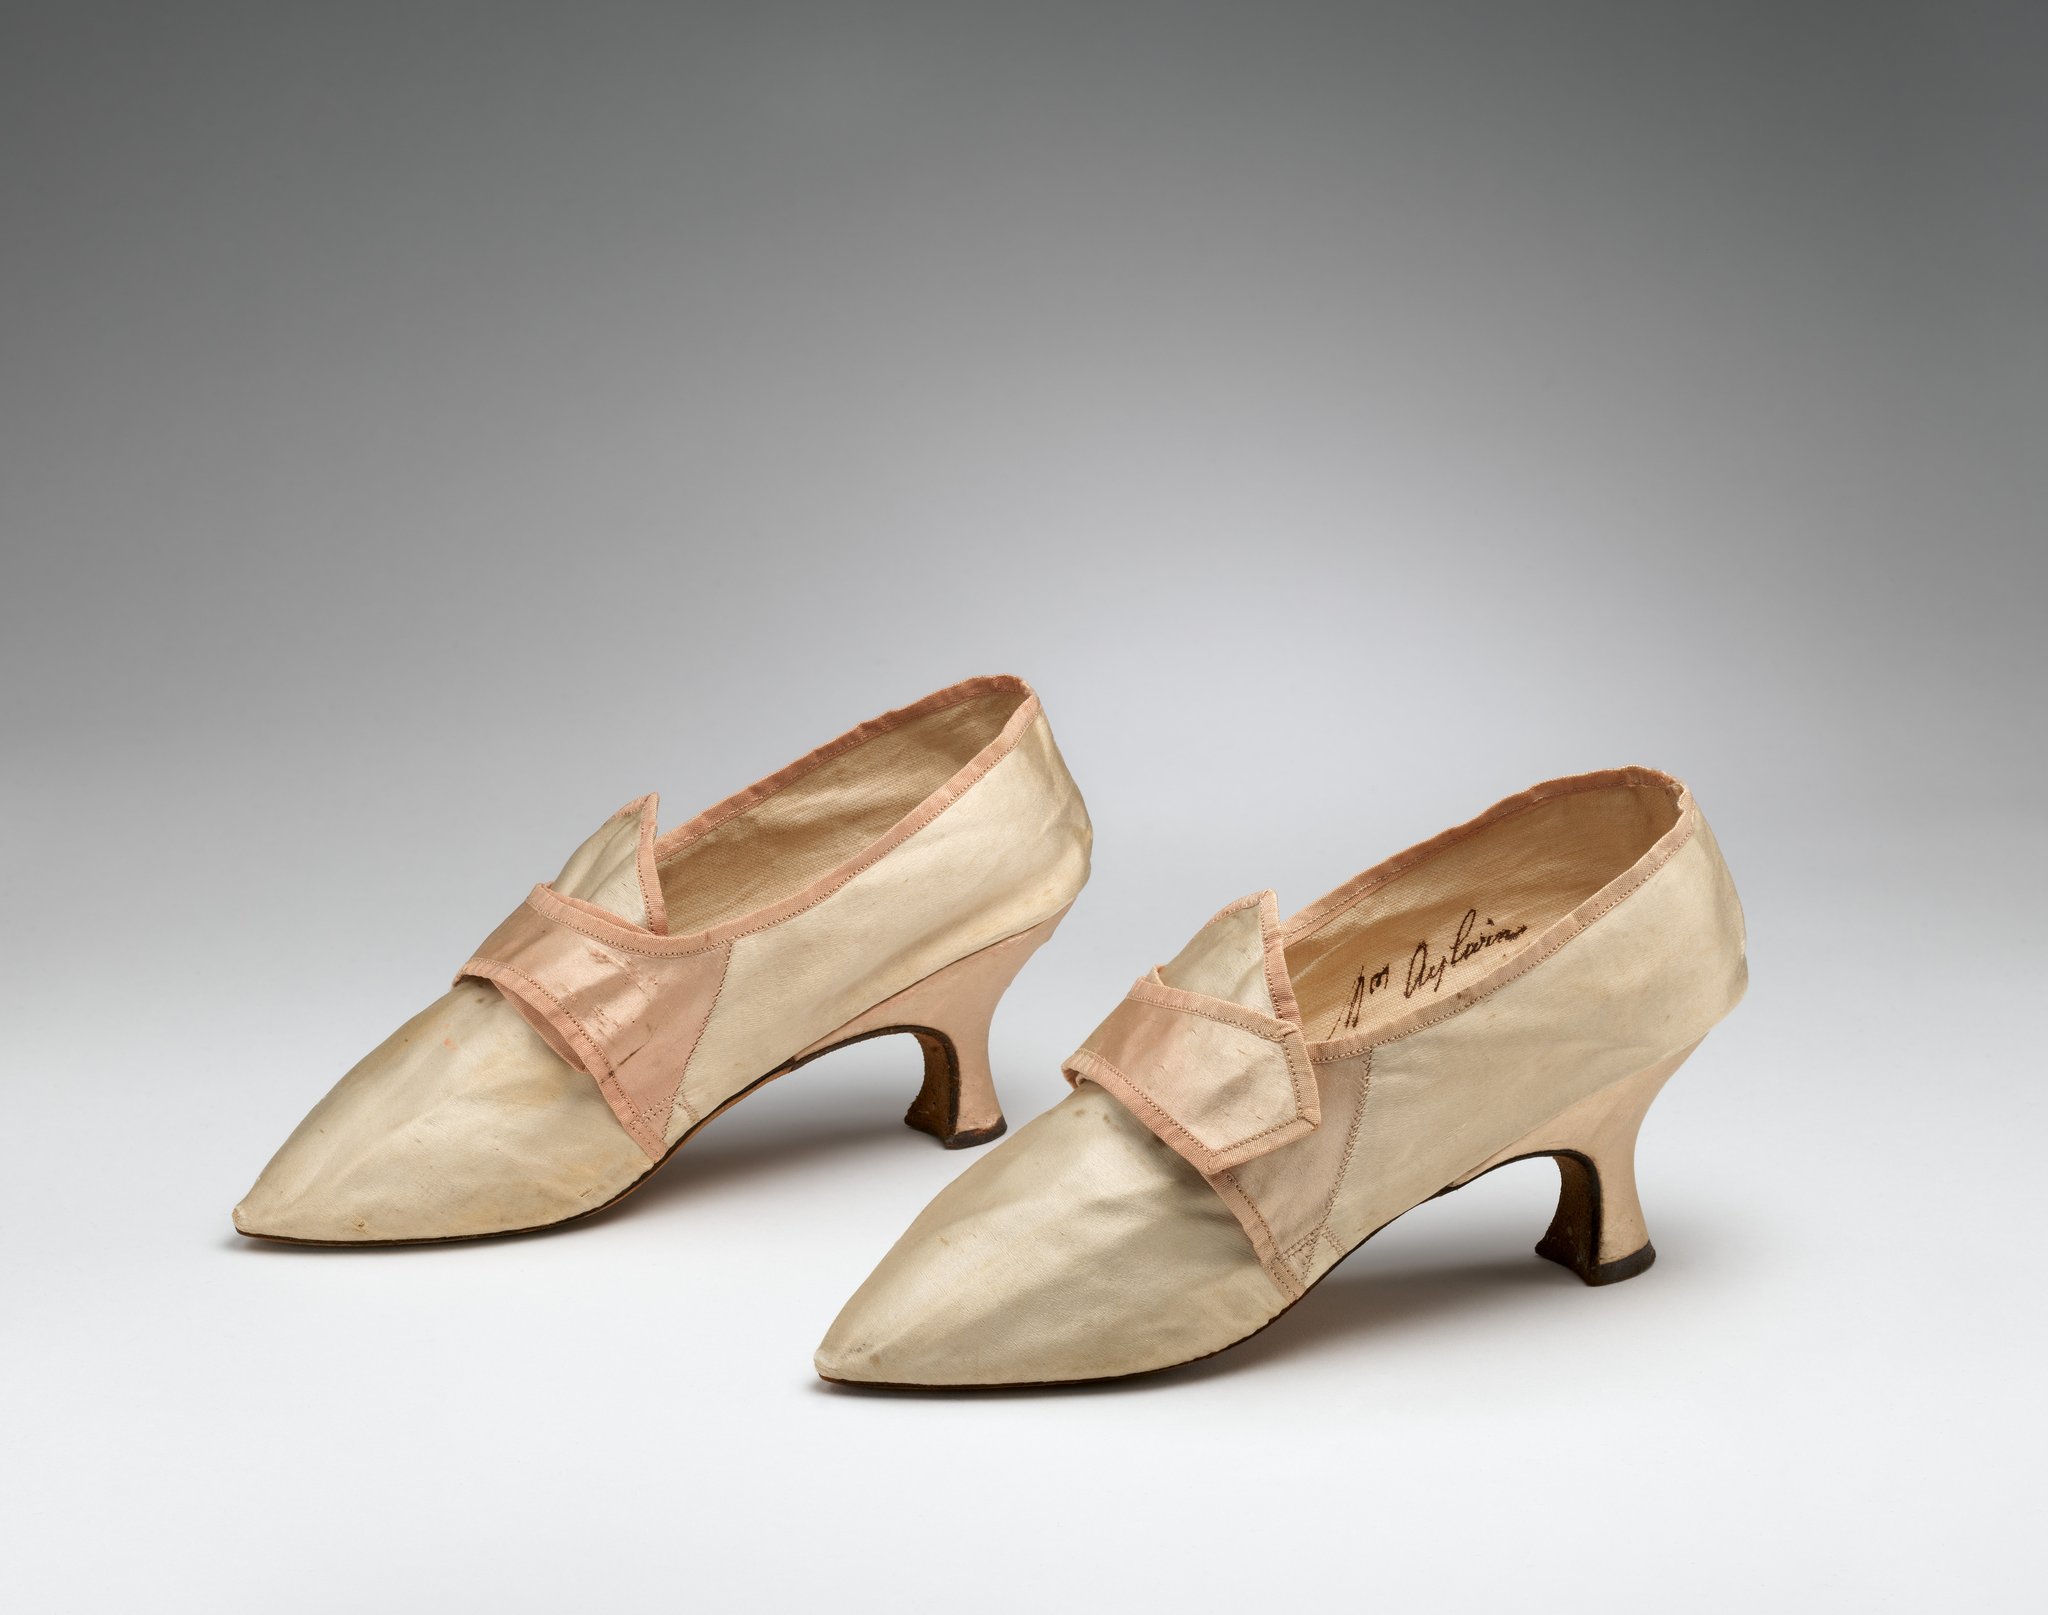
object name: shoe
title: Shoes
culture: british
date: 1780-1789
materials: silk